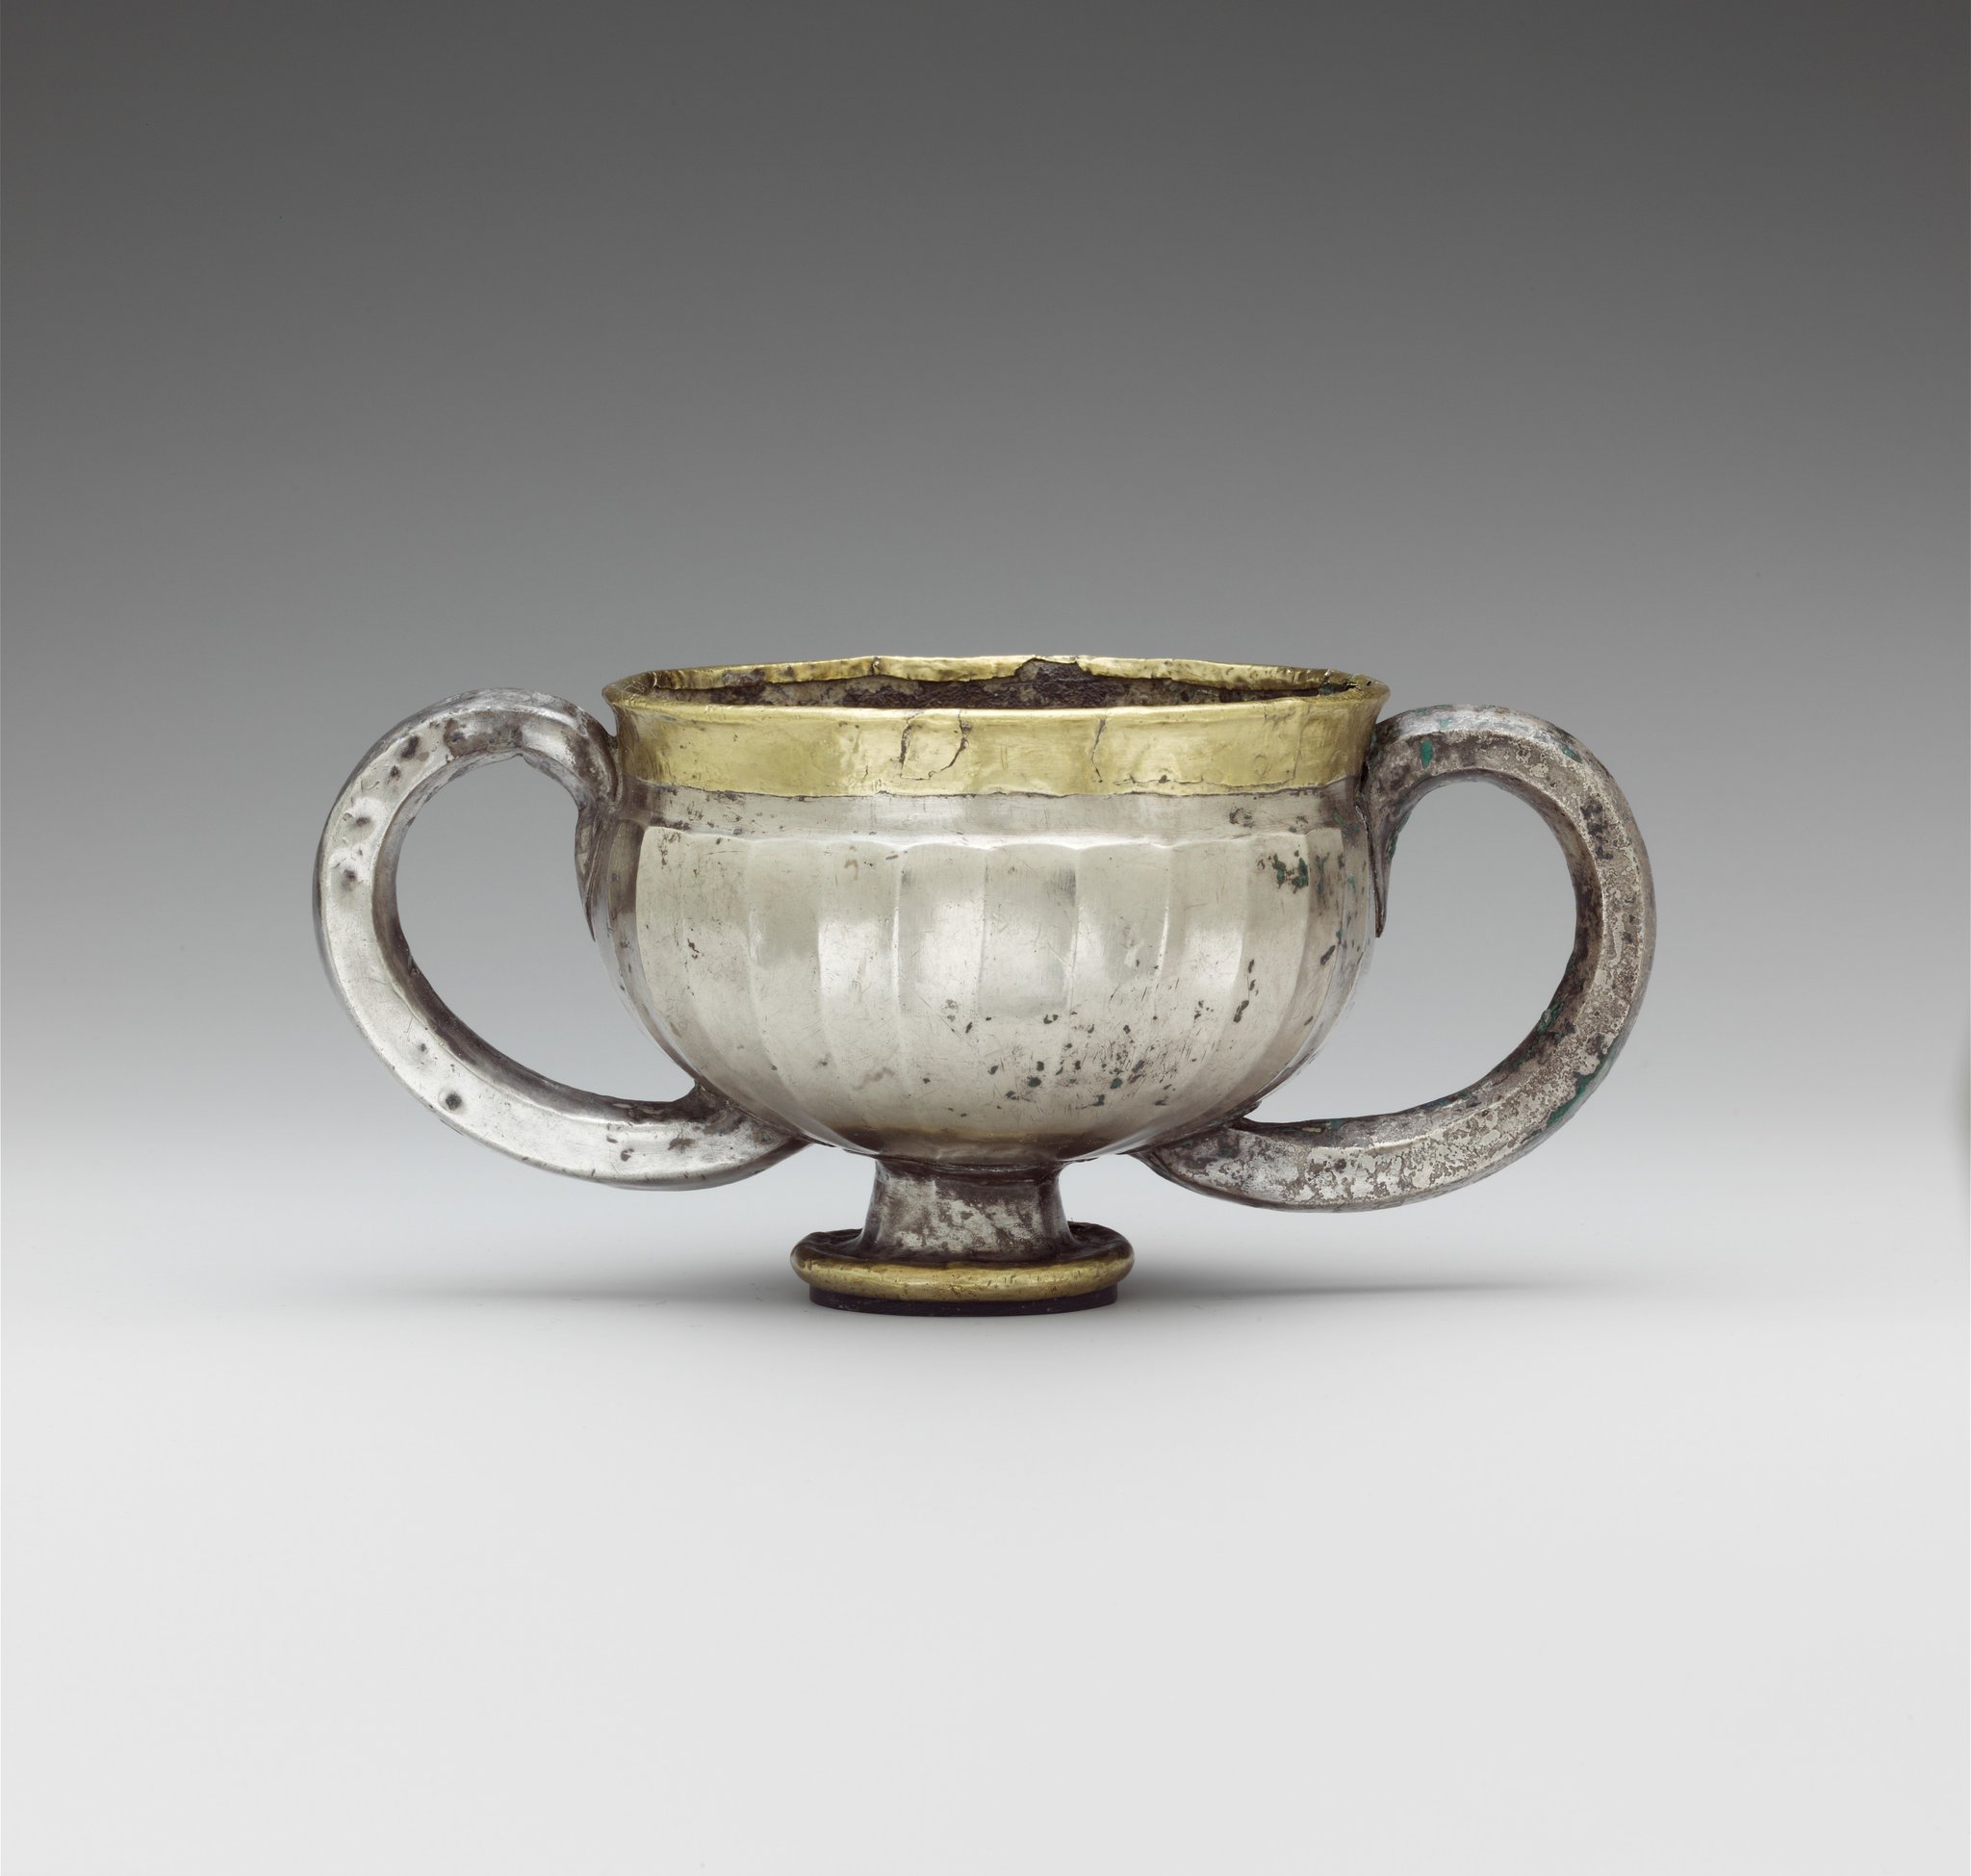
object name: cup, one handled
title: Gilded silver cup with two handles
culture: anatolian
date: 2300-2000 BCE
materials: gold foil, silver